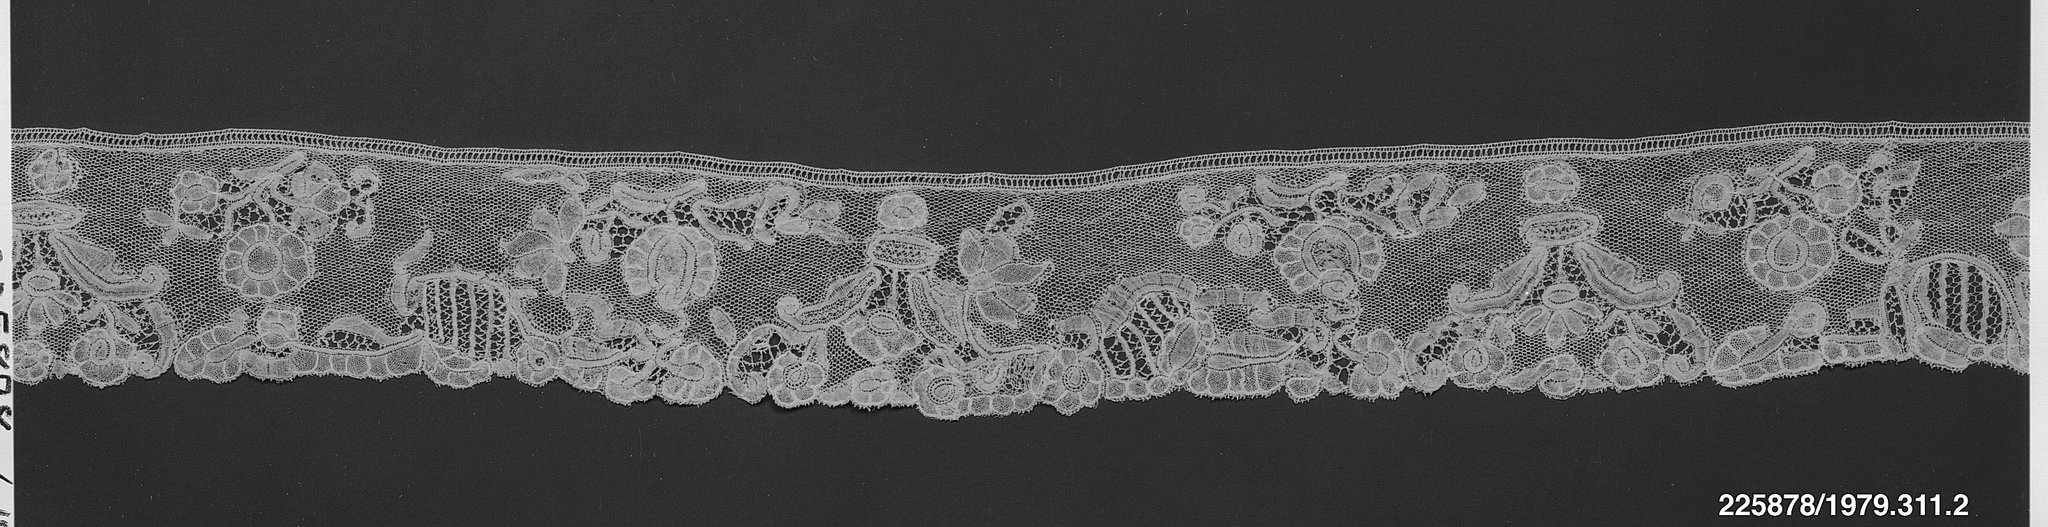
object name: edging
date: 1734-1766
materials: lace, linen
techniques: lace